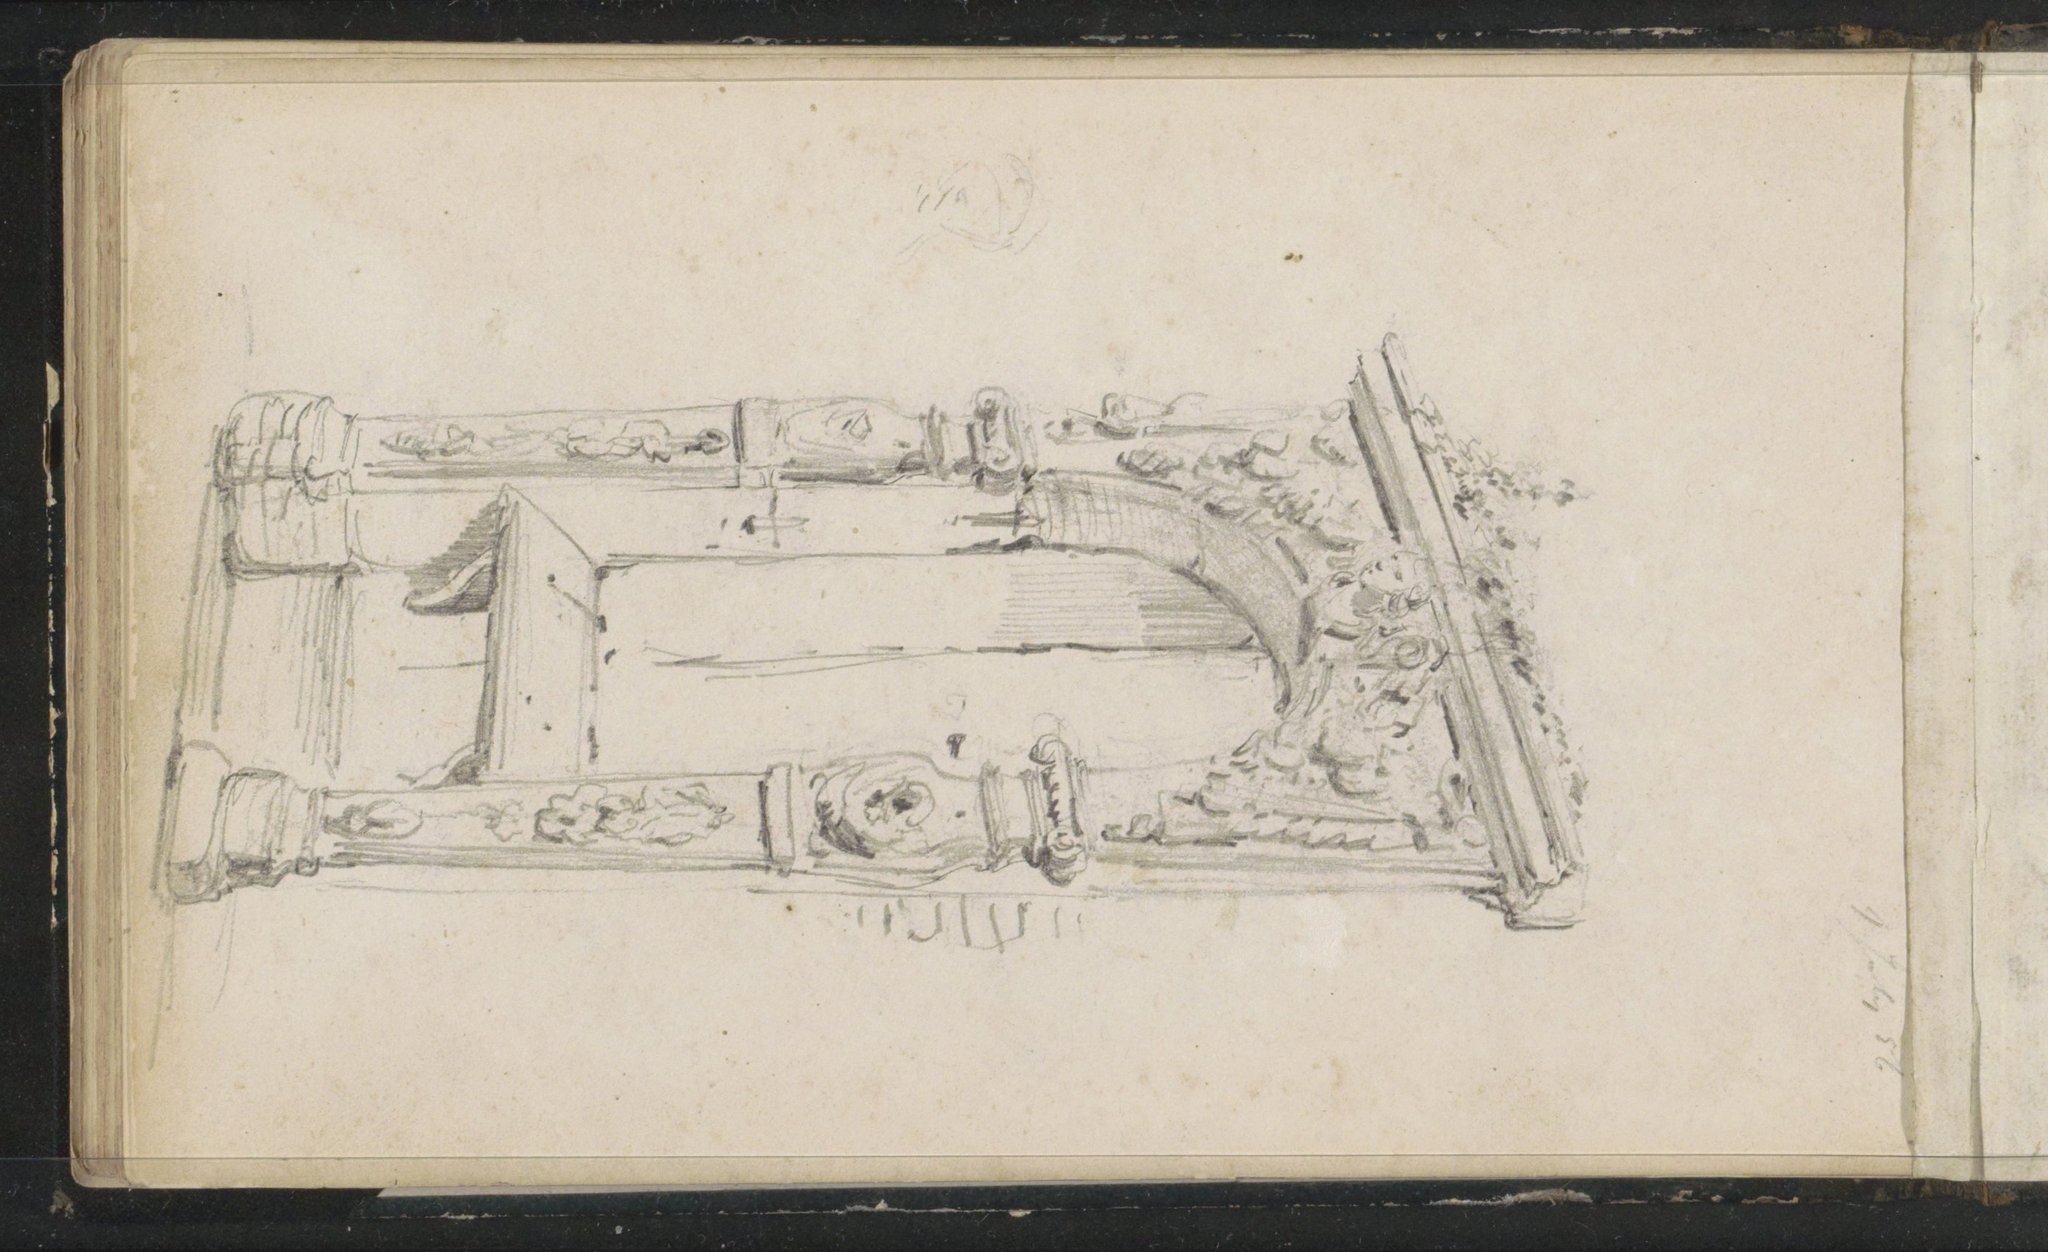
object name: sketchbook leaf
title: Gezicht op een nis, omgeven door een rondboog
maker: cornelis springer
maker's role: draughtsman, painter, print maker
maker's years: 1817-1891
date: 1856-1861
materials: paper, pencil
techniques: stumping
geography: netherlands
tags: writing-table, writing-desk, arch, archivolt ~ architecture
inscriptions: date: ‘9 July 56’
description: Gezicht op een nis, omgeven door een rondboog. In de nis mogelijk een lessenaar. Blad 44 verso uit een schetsboek met 44 bladen vervaardigd in Zeeland en Utrecht.